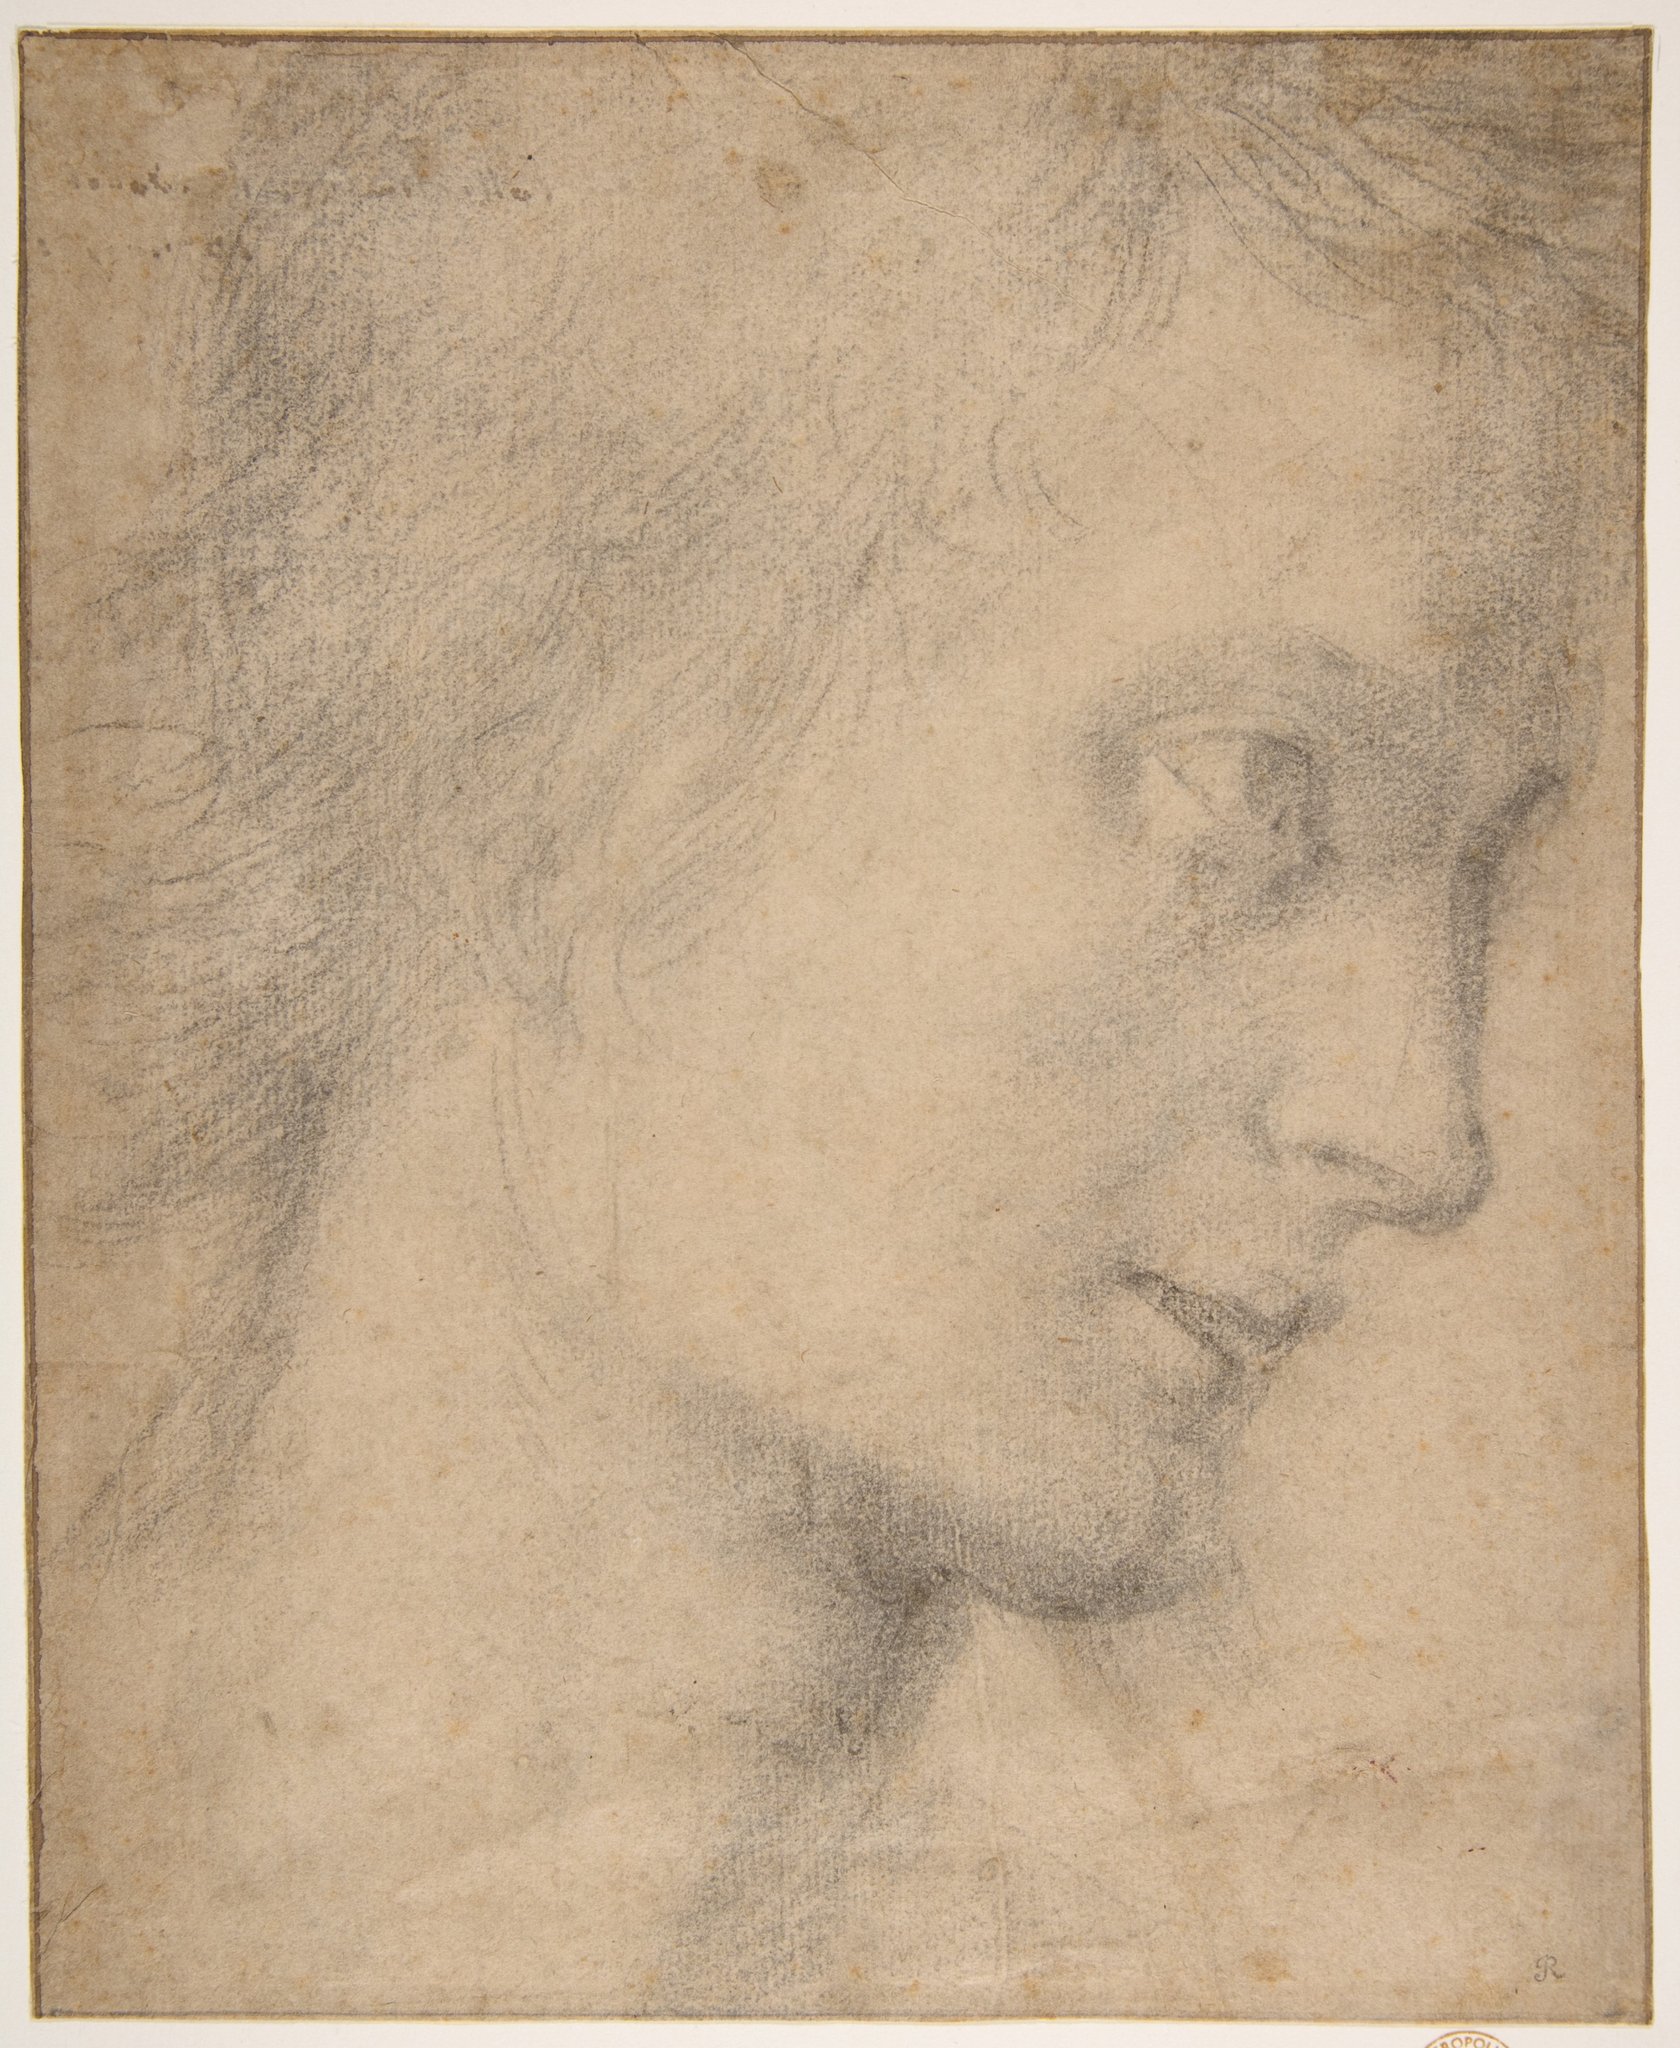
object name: drawing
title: Head of a Youth in Profile (recto); Study of a Seated Figure (verso)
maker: giovanni antonio sogliani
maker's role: artist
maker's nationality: italian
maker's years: 1492-1544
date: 1525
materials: chalk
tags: boys,profiles